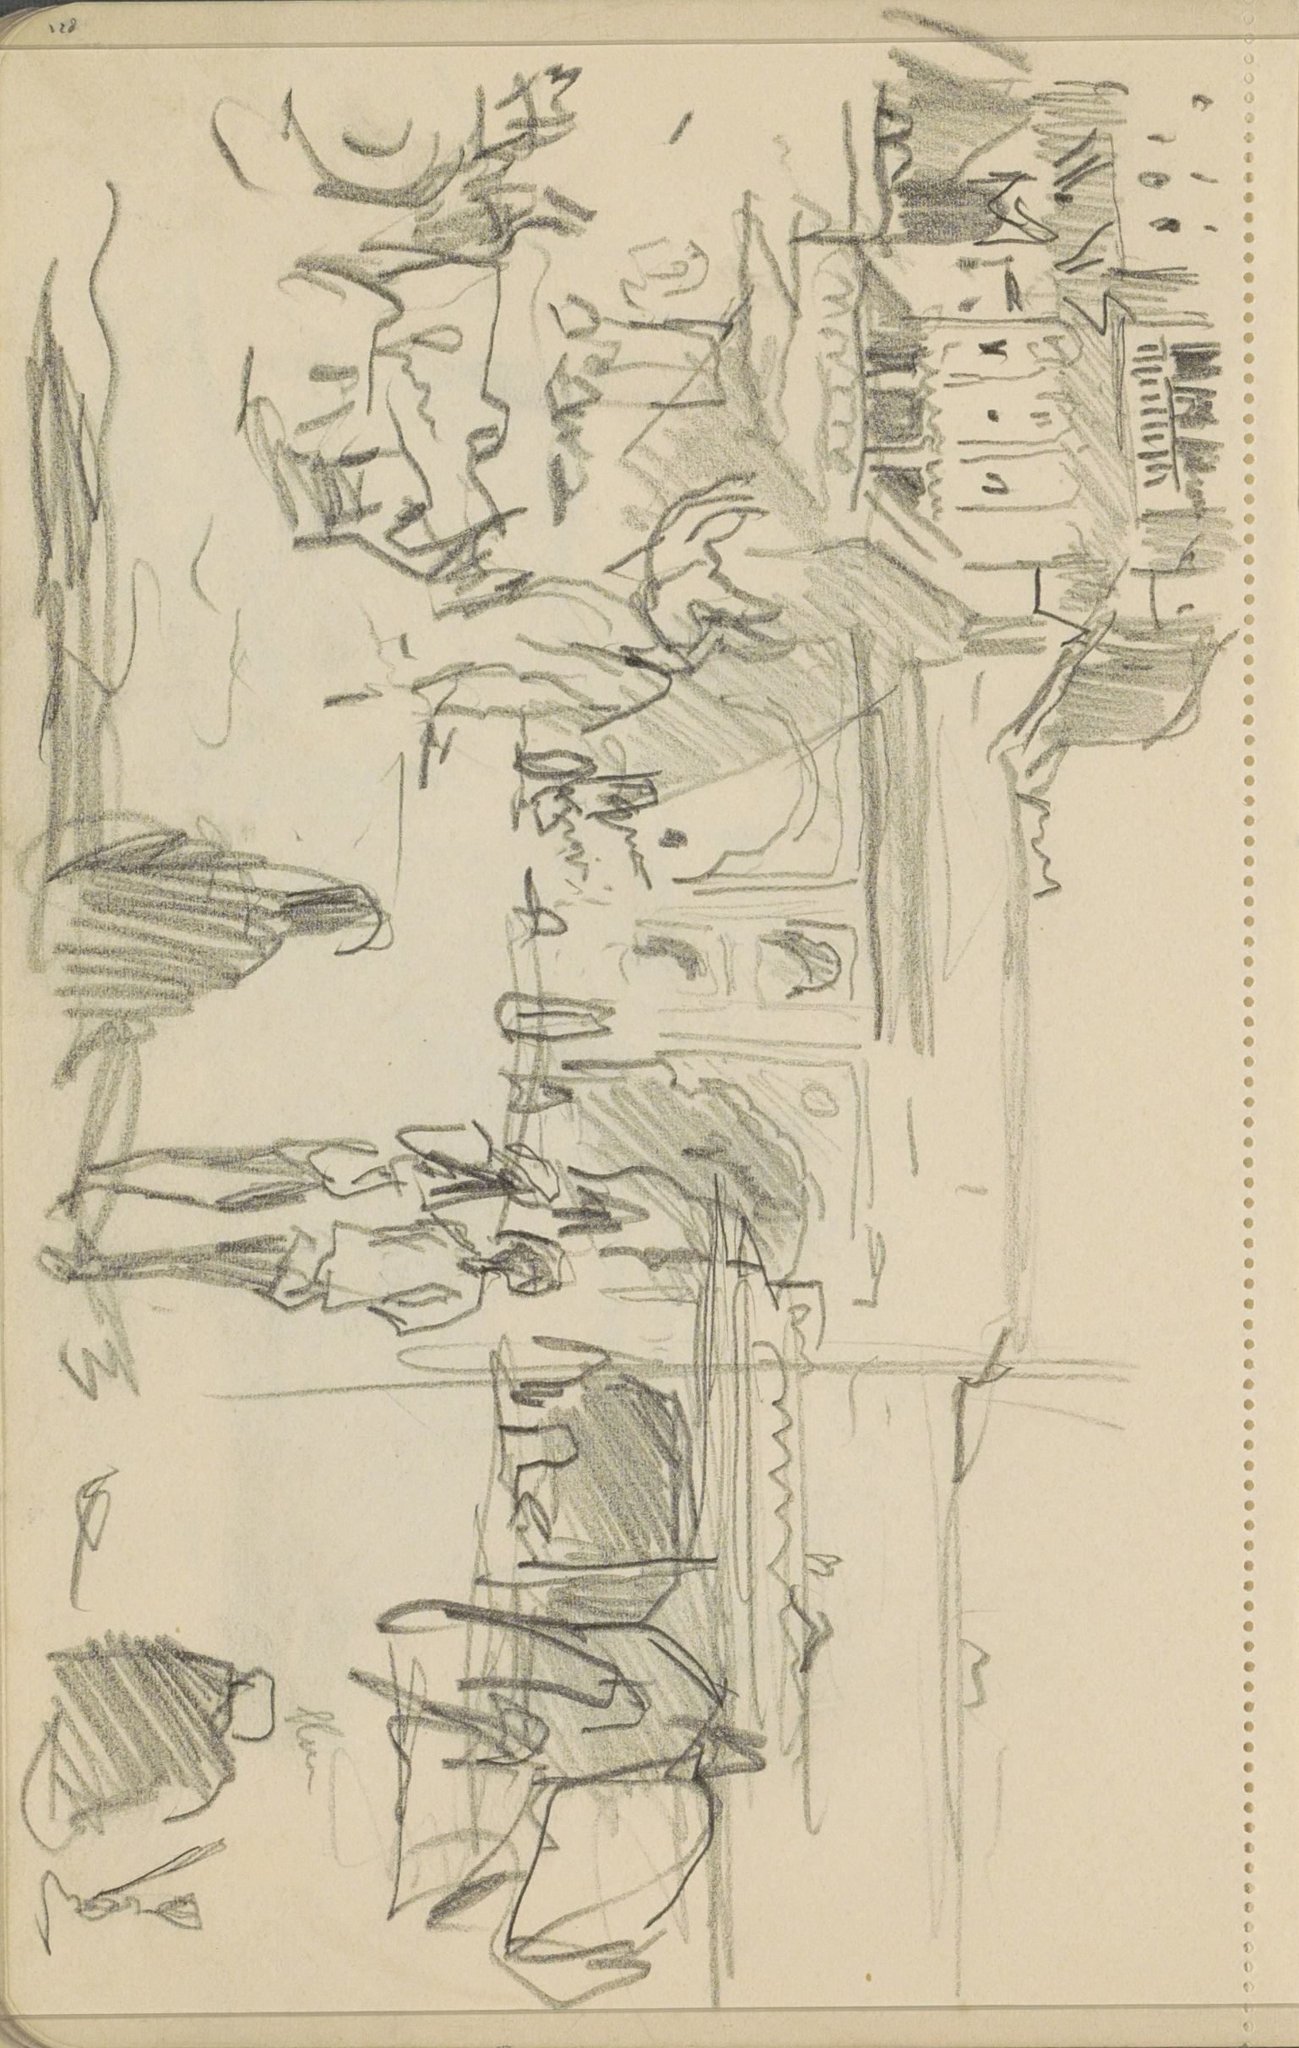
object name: sketchbook leaf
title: Straatscène in India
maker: marius bauer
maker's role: draughtsman, print maker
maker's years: 1867-1932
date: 1924-1925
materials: paper, pencil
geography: india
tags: asiatic races and peoples: indians, street (+ city(-scape) with figures, staffage)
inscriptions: kleurnotitie, handgeschreven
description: Pagina 128 uit een schetsboek met 87 bladen.